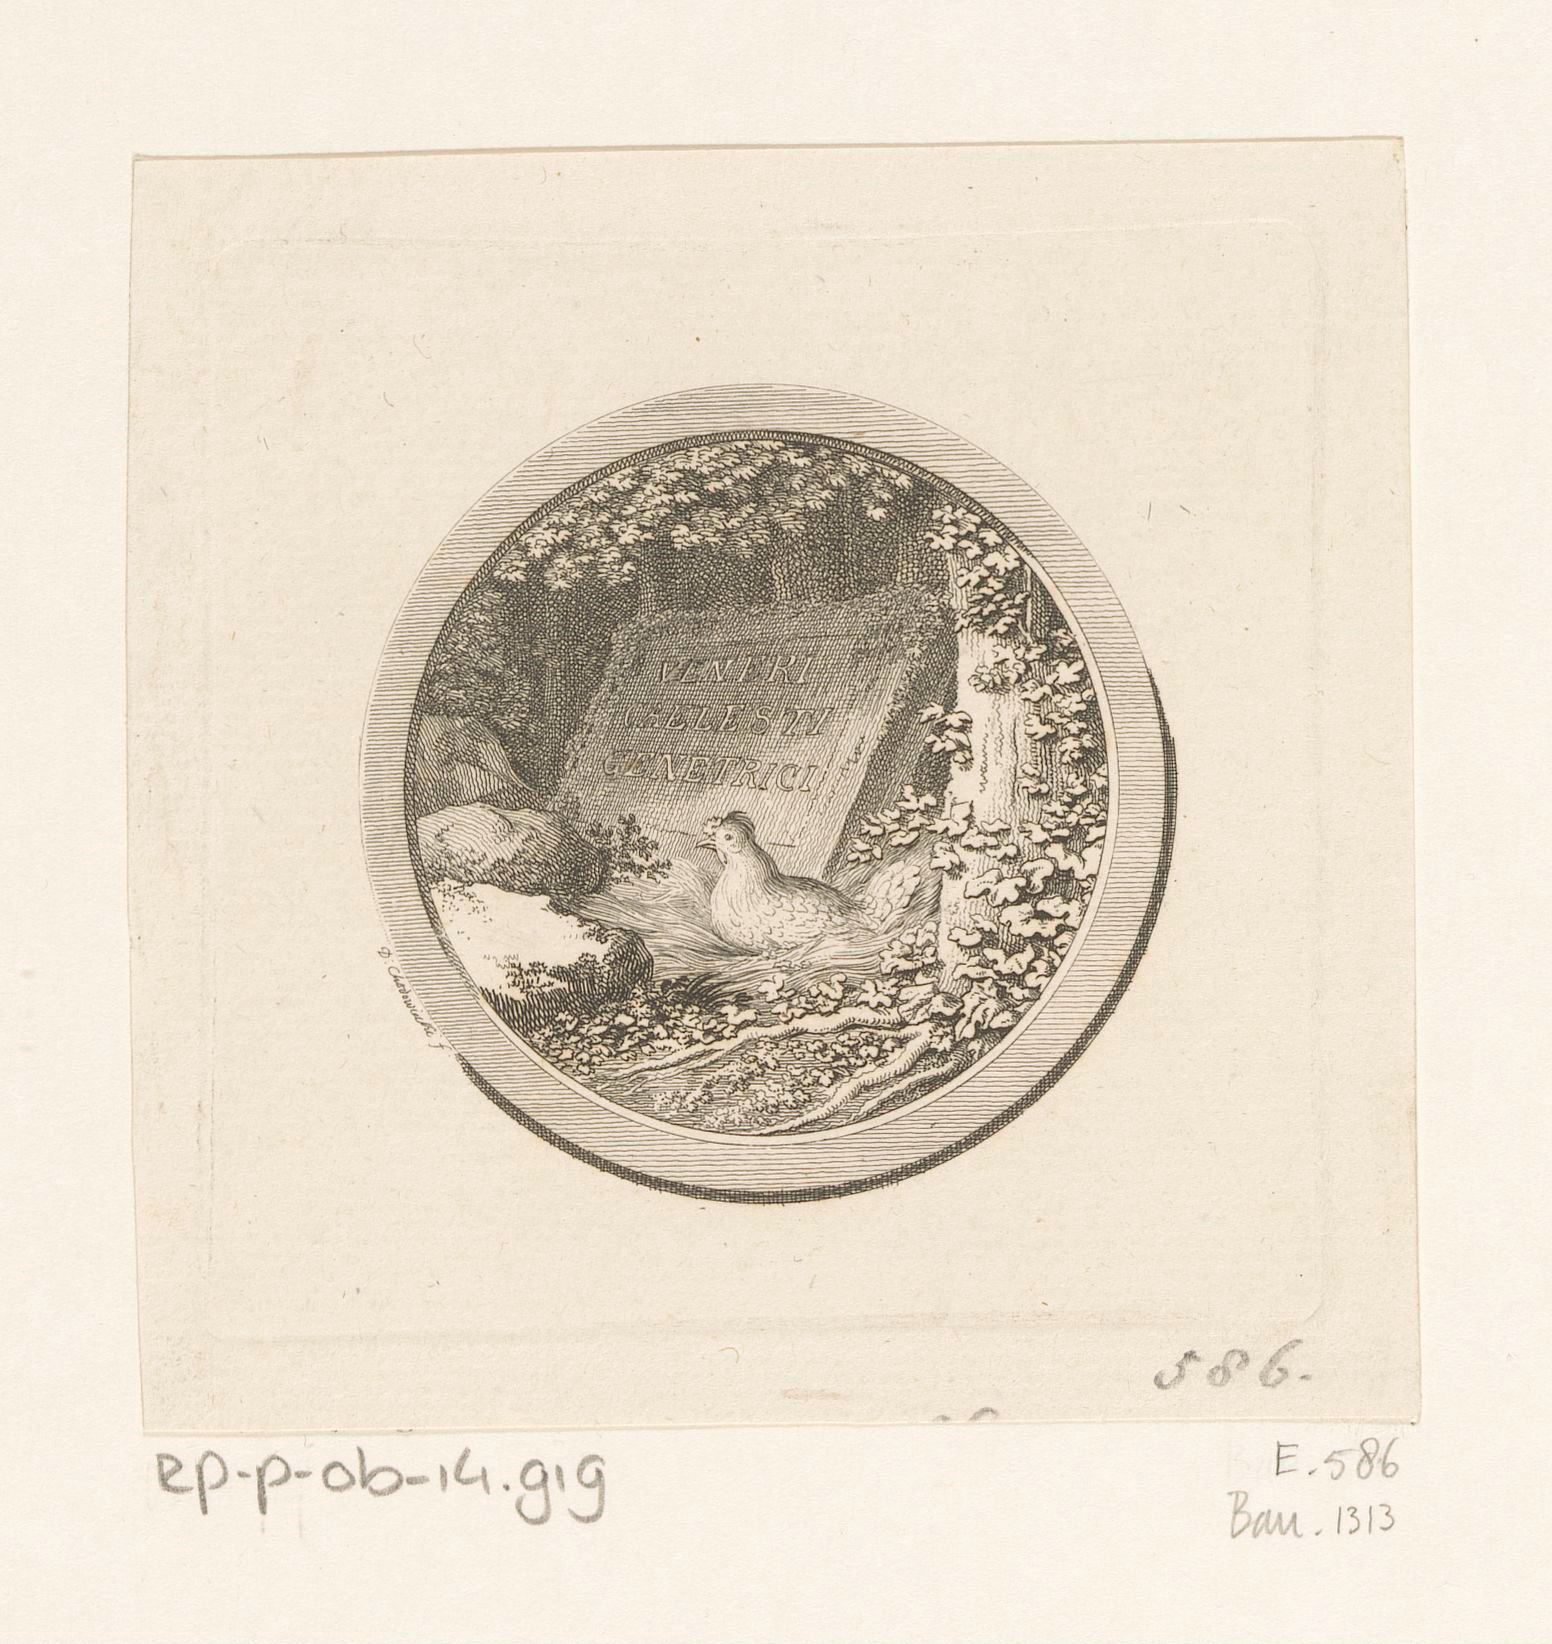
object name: print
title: Kip op haar nest, daar achter een steen waarin de tekst 'Venus hemelse moeder' is gehouwen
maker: daniel nikolaus chodowiecki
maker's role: draughtsman, print maker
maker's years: 1726-1801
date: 1787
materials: paper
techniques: etching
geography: berlin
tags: physicist, clay tablet, stone tablet, forest, wood, fowl (cock, hen, chicken, etc.)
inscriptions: collector's mark: Lugt 2228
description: Prent gebruikt in: Blumenbach, Johann Friedrich. Über den Bildungstrieb. Göttingen: Johann Christoph Dietrich, 1789.